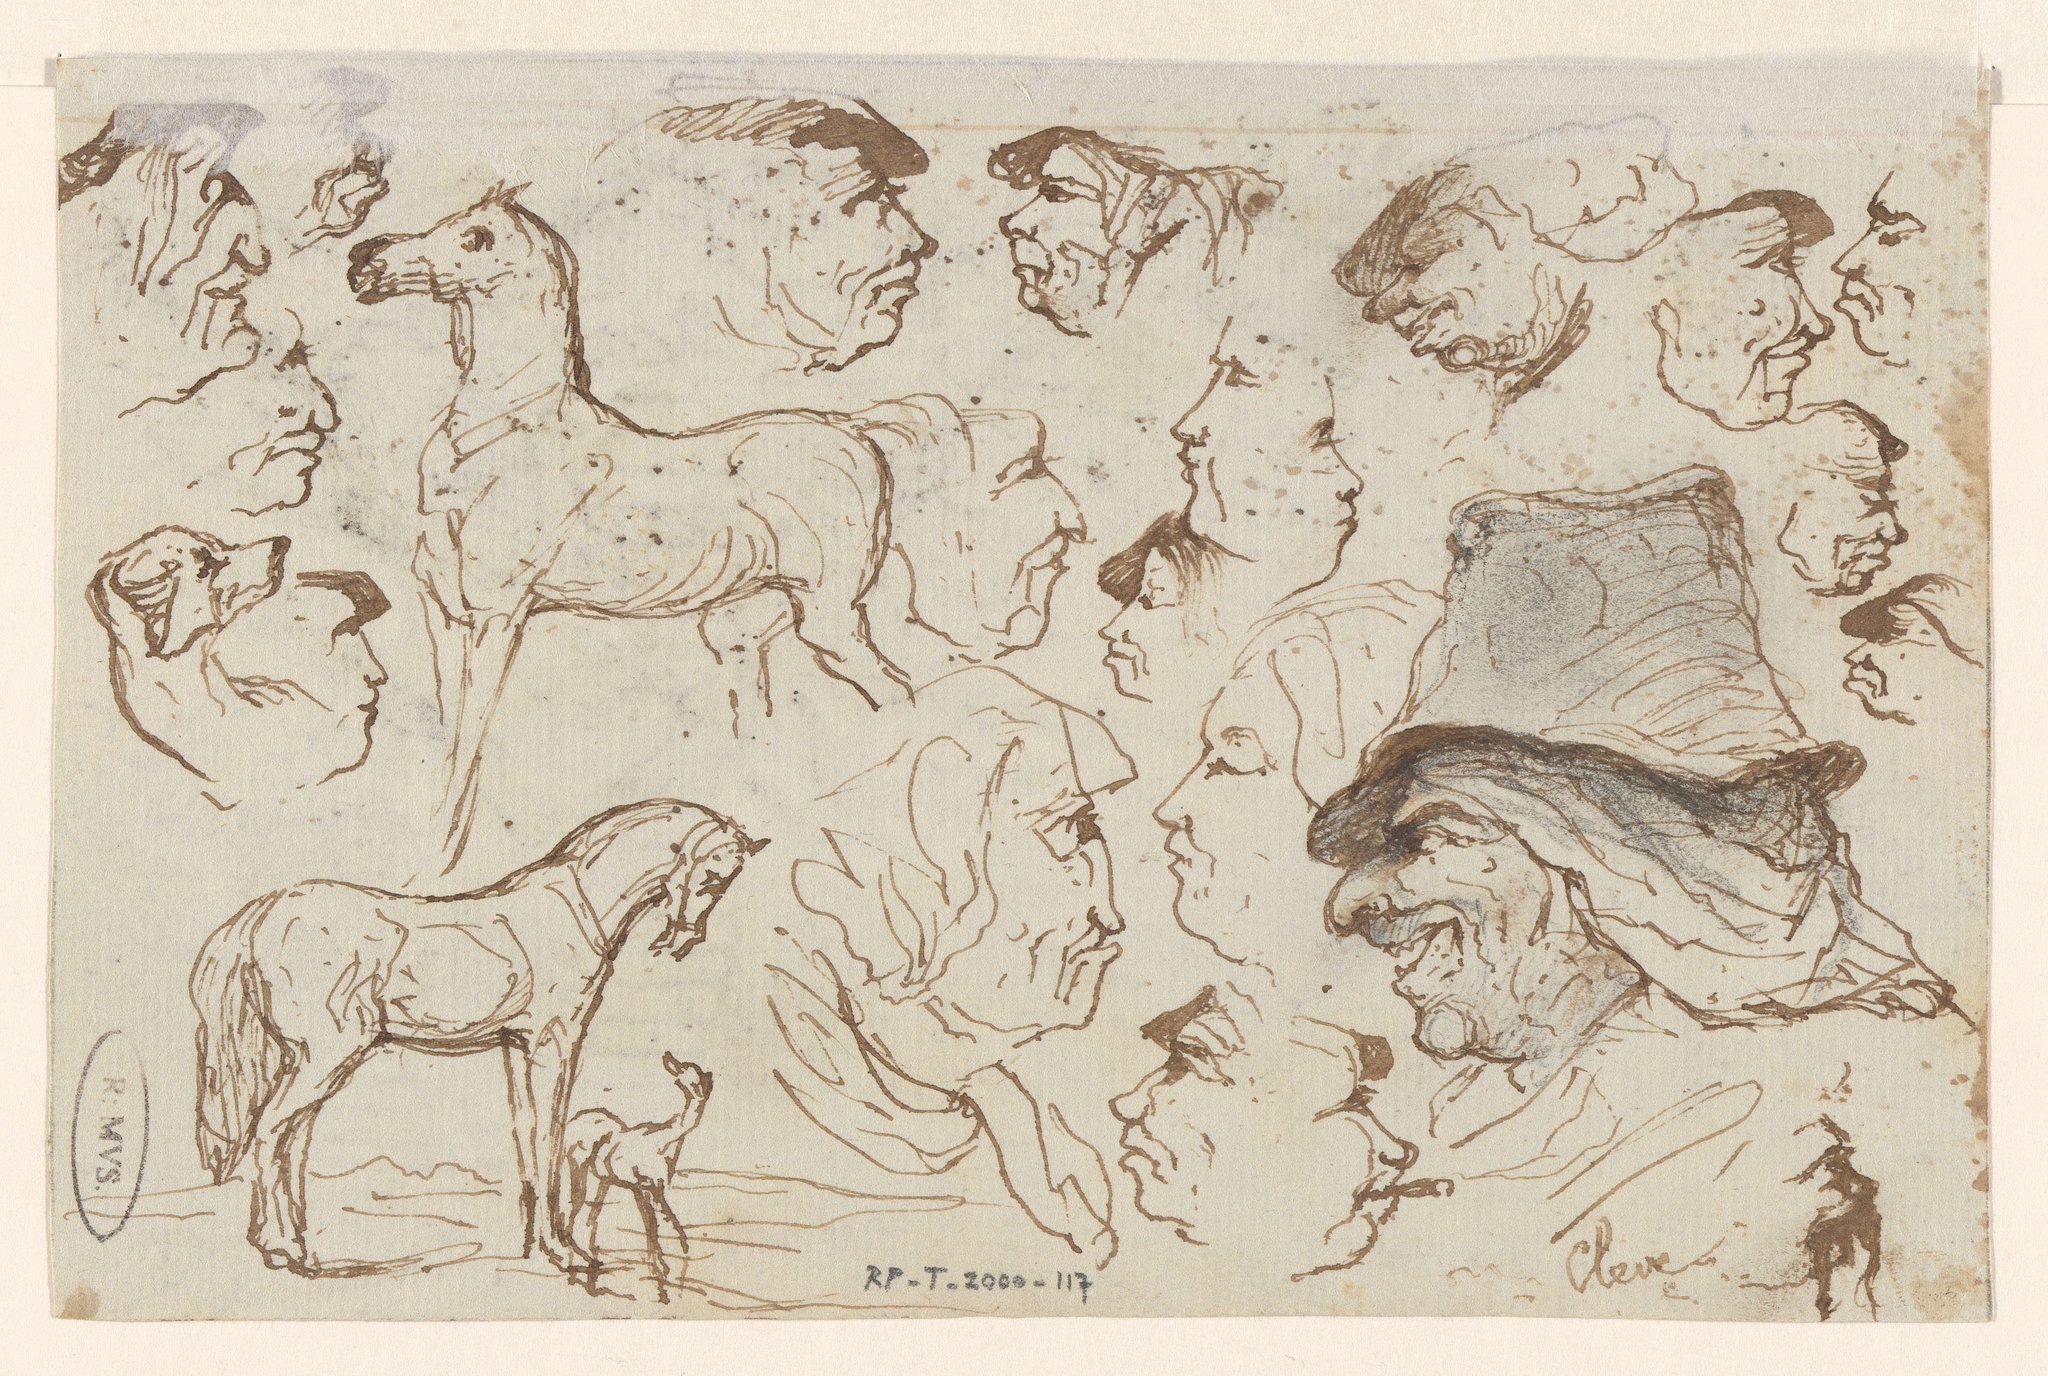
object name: drawing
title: Paarden en karikaturale koppen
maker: johannes tavenraat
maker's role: draughtsman, painter, print maker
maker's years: 1809-1881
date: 1835-1845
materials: ink, paper, pencil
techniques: pen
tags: caricatures (human types), horse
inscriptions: annotation: ‘Cleve’, collector's mark: Lugt 2228